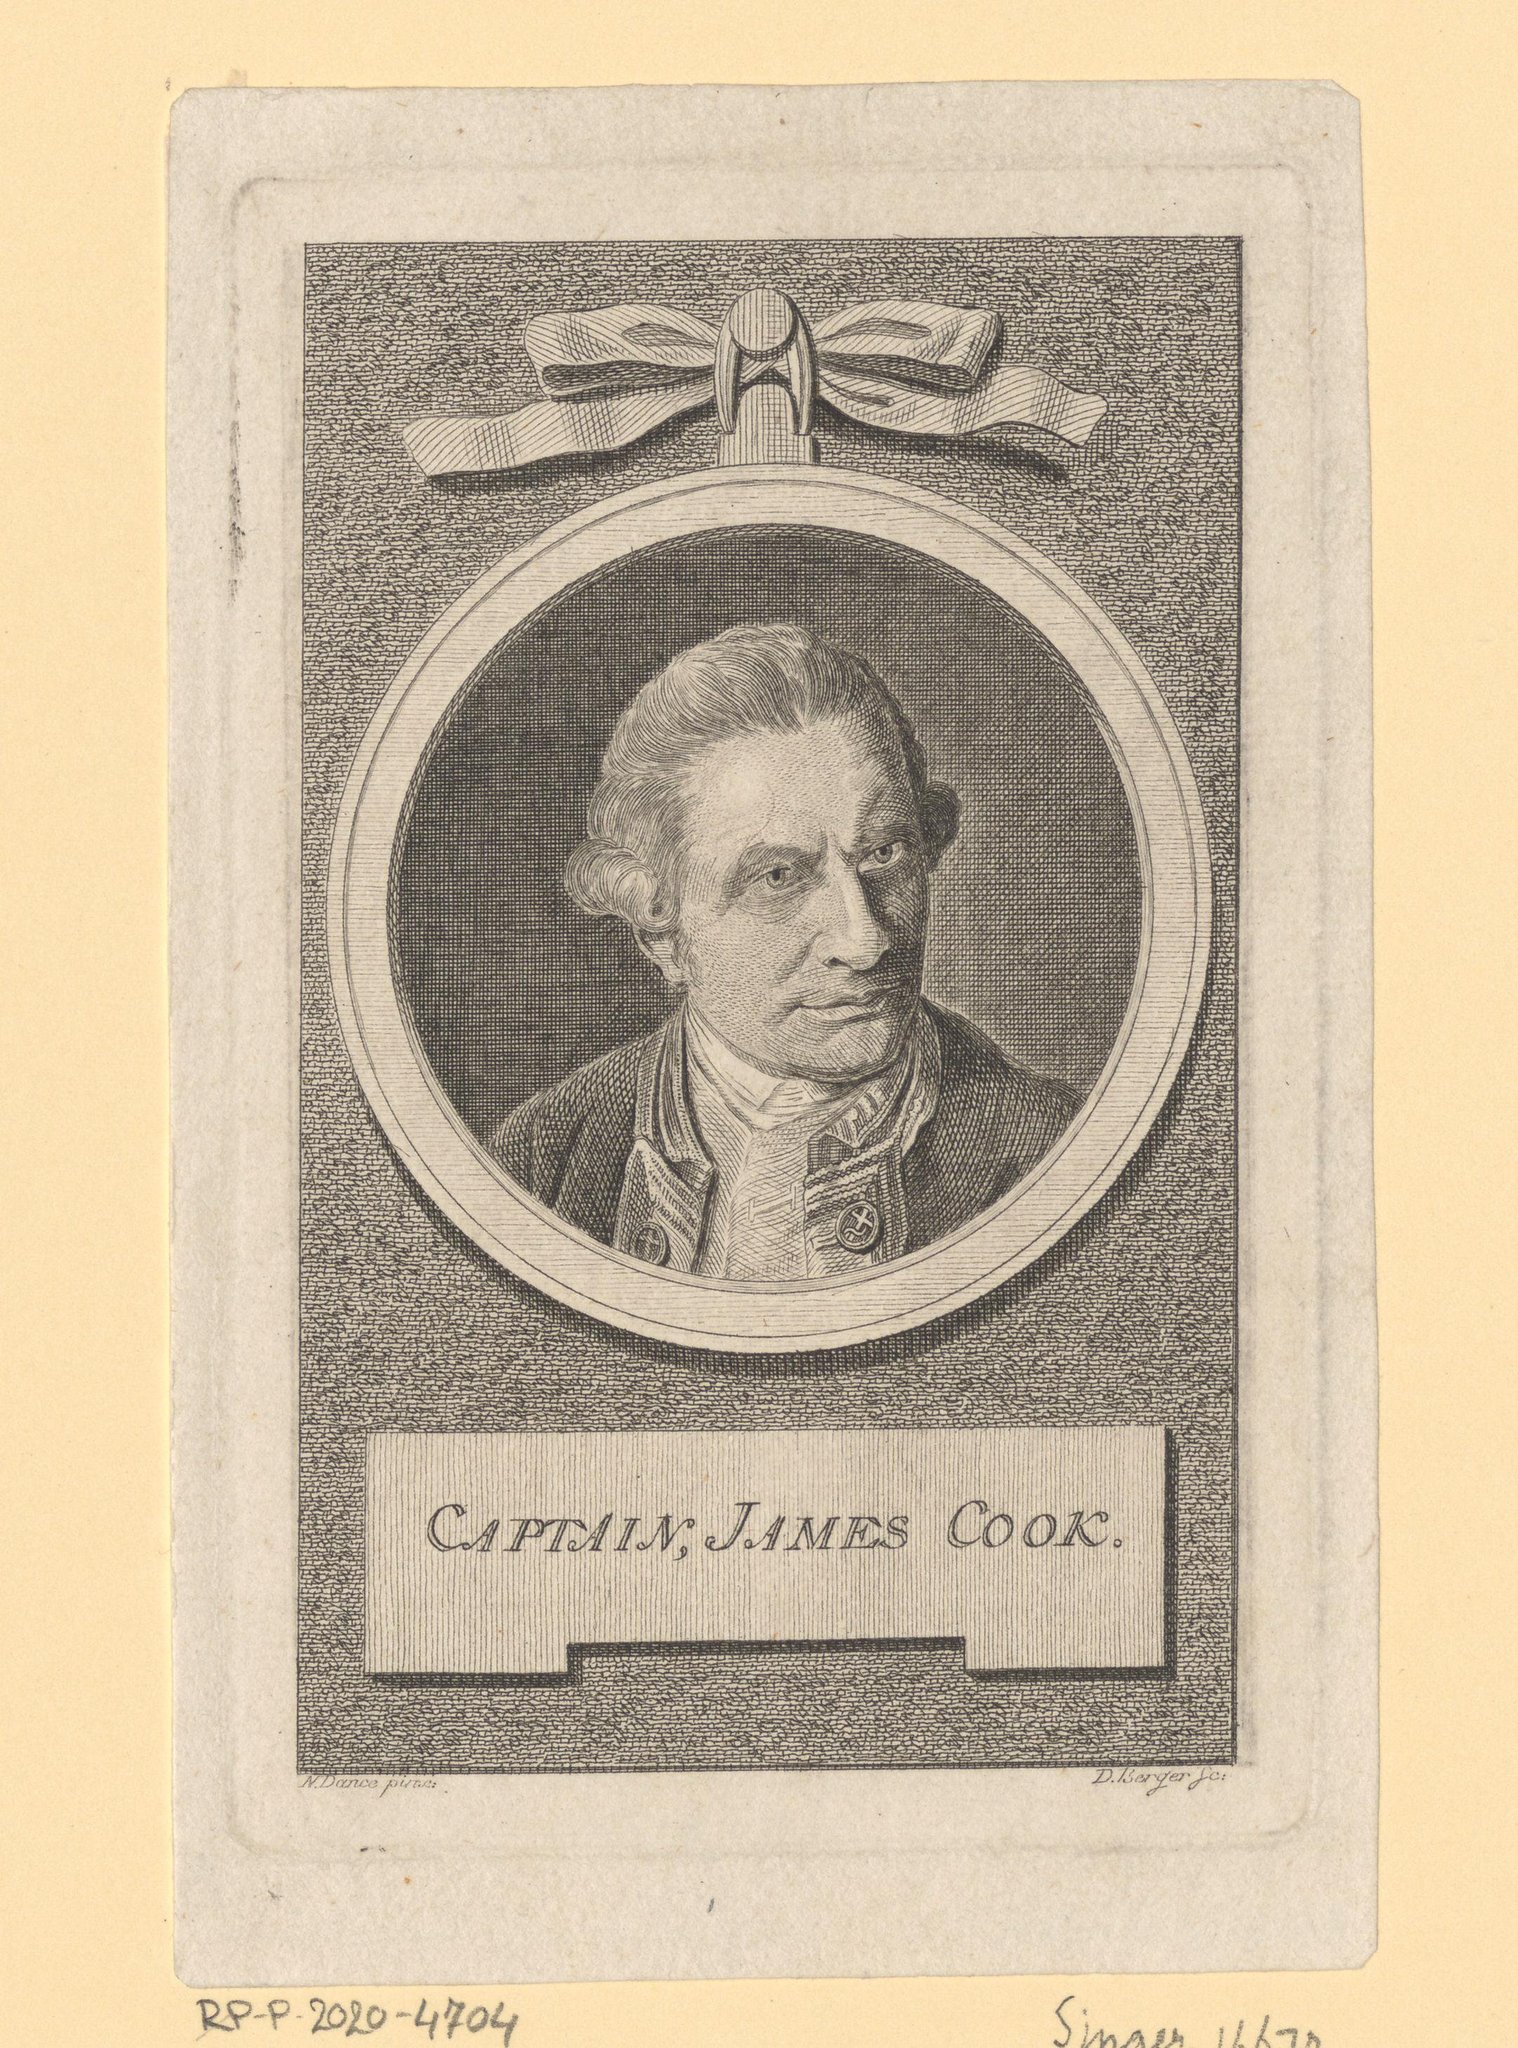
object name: print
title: Portret van James Cook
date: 1766-1824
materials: paper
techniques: engraving, etching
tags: james cook, historical persons